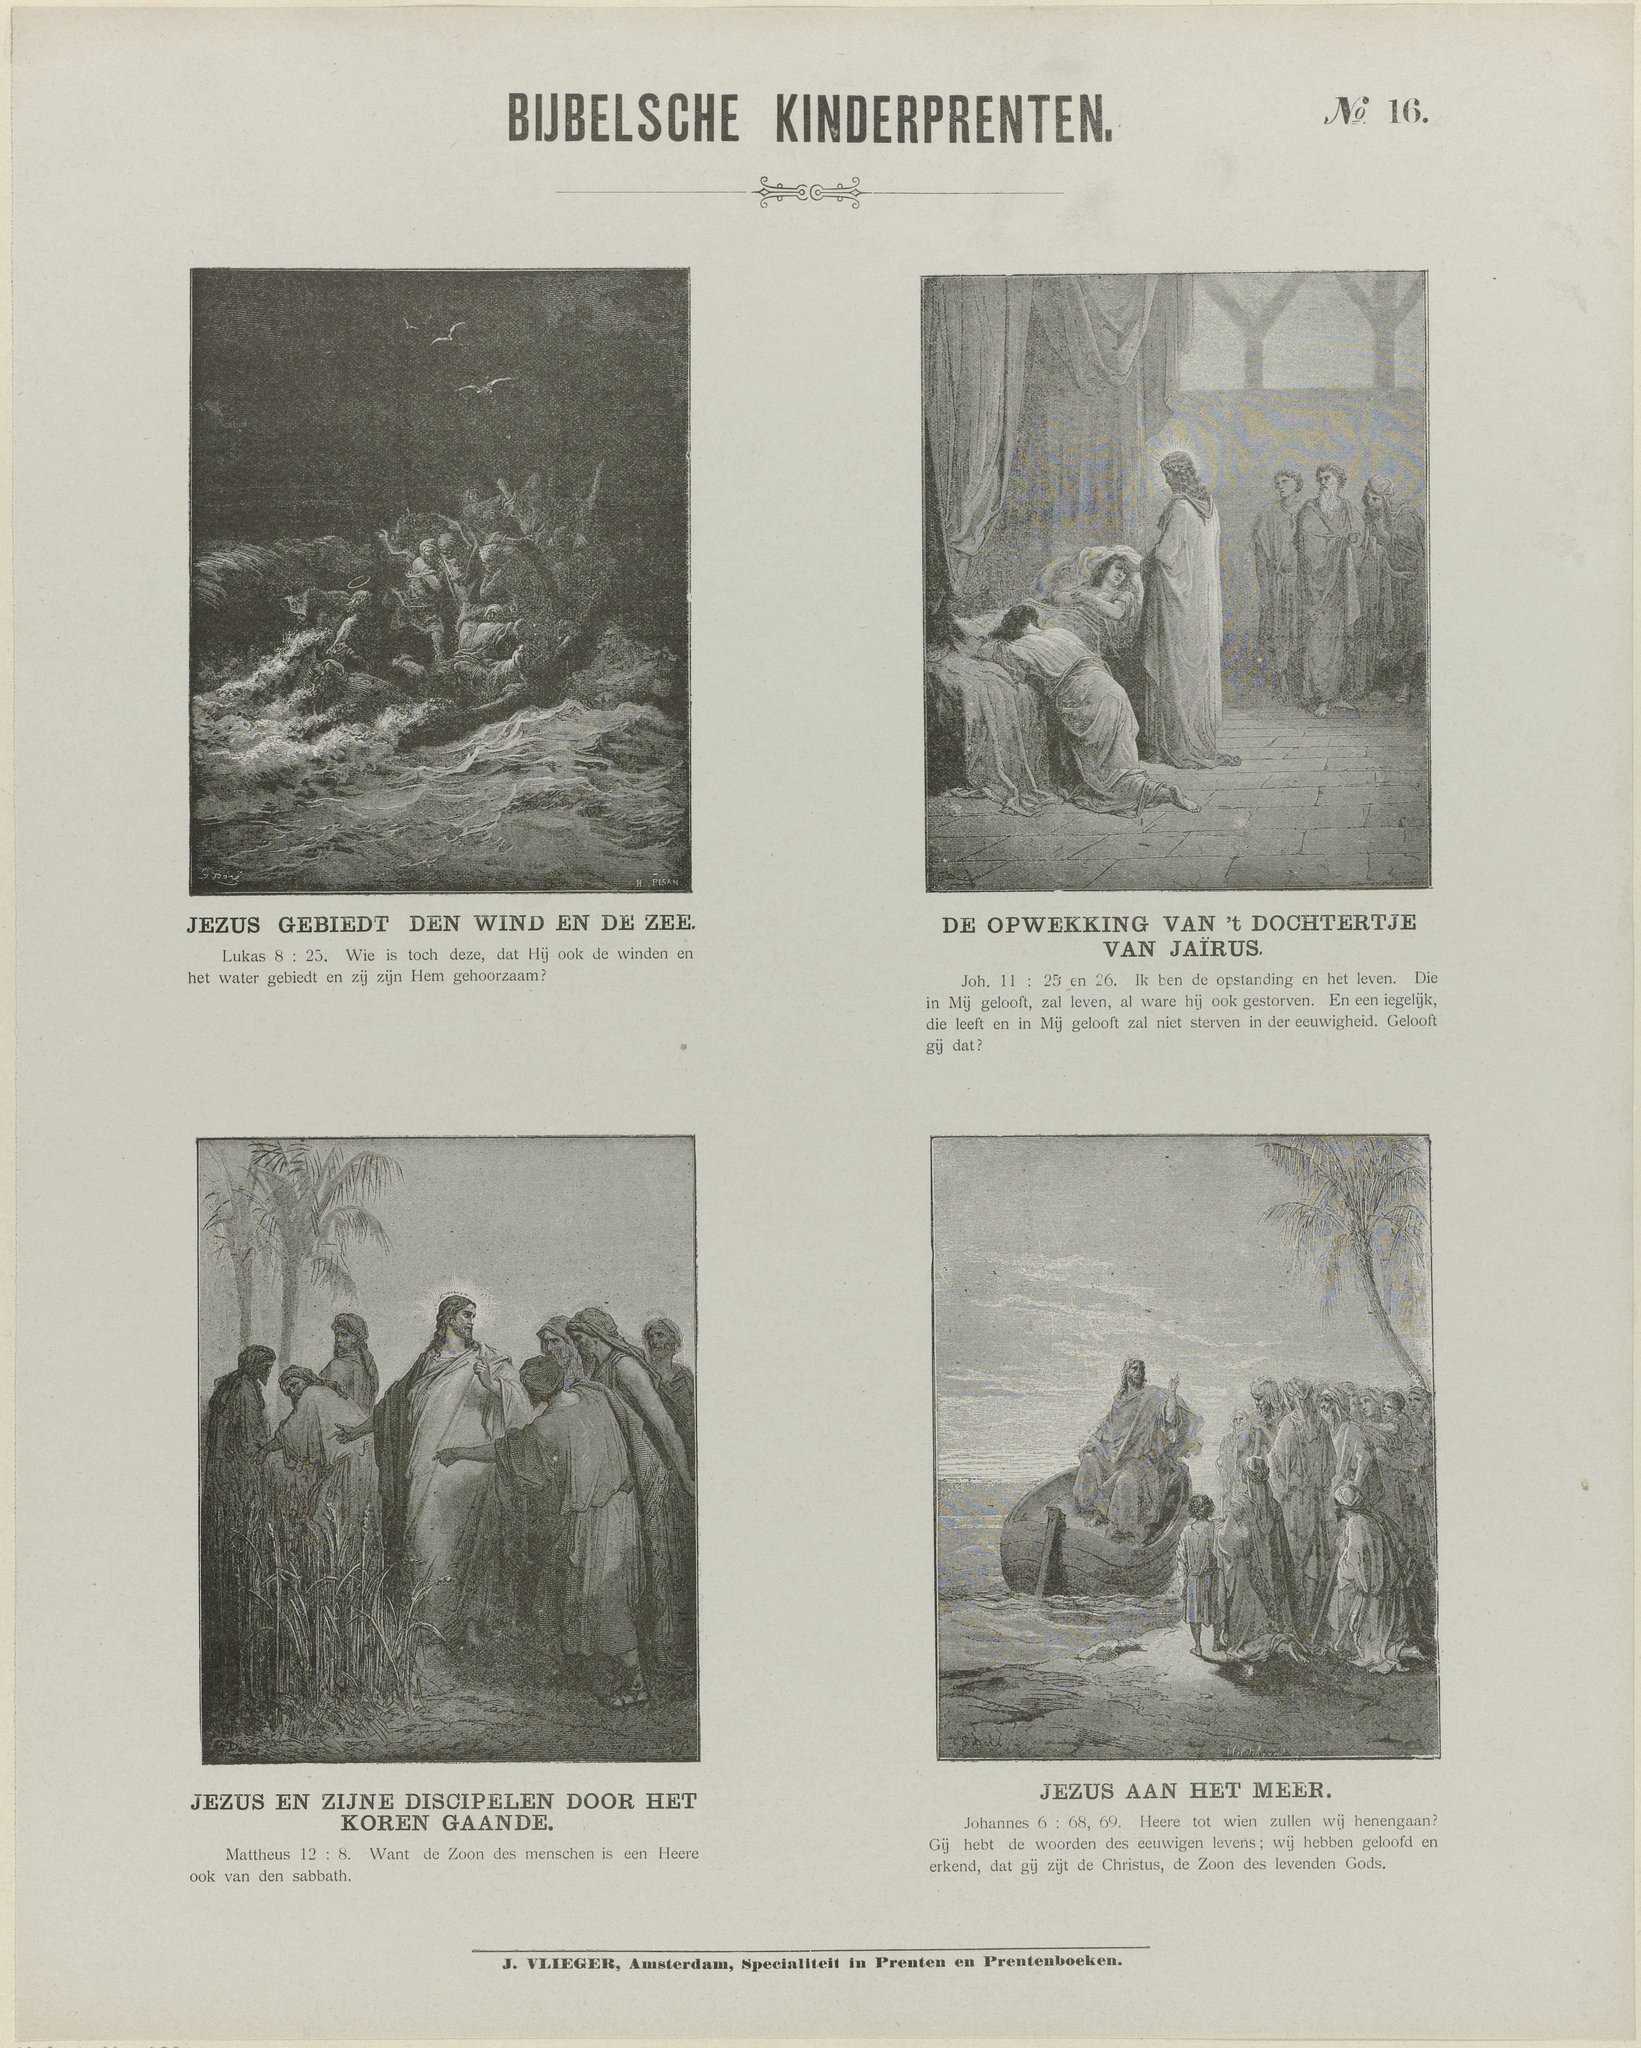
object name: print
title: Bijbelsche kinderprenten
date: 1869-1908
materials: paper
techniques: letterpress printing, photoaquatint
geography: amsterdam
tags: christ rebuking the winds, raising of the daughter of jairus, who is lying in bed (matthew 9:18-19, 9:23-26; mark 5:21-24, 5:35-43; luke 8:40-42, 8:49-56), adult christ together with apostles, evangelists, saints, etc., new testament, christ in peter's boat preaching to the people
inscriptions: collector's mark: Lugt 2760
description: Blad met 4 voorstellingen van verhalen uit het Nieuwe Testament. Christus en de apostelen tijdens een storm op zee, de opwekking van het dochtertje van Jaïrus, Christus en zijn apostelen gaan door het koren en Jezus preekt vanaf de boot van Petrus tot de mensen. Onder elke afbeelding een Bijbeltekst. Genummerd rechtsboven: No. 16.